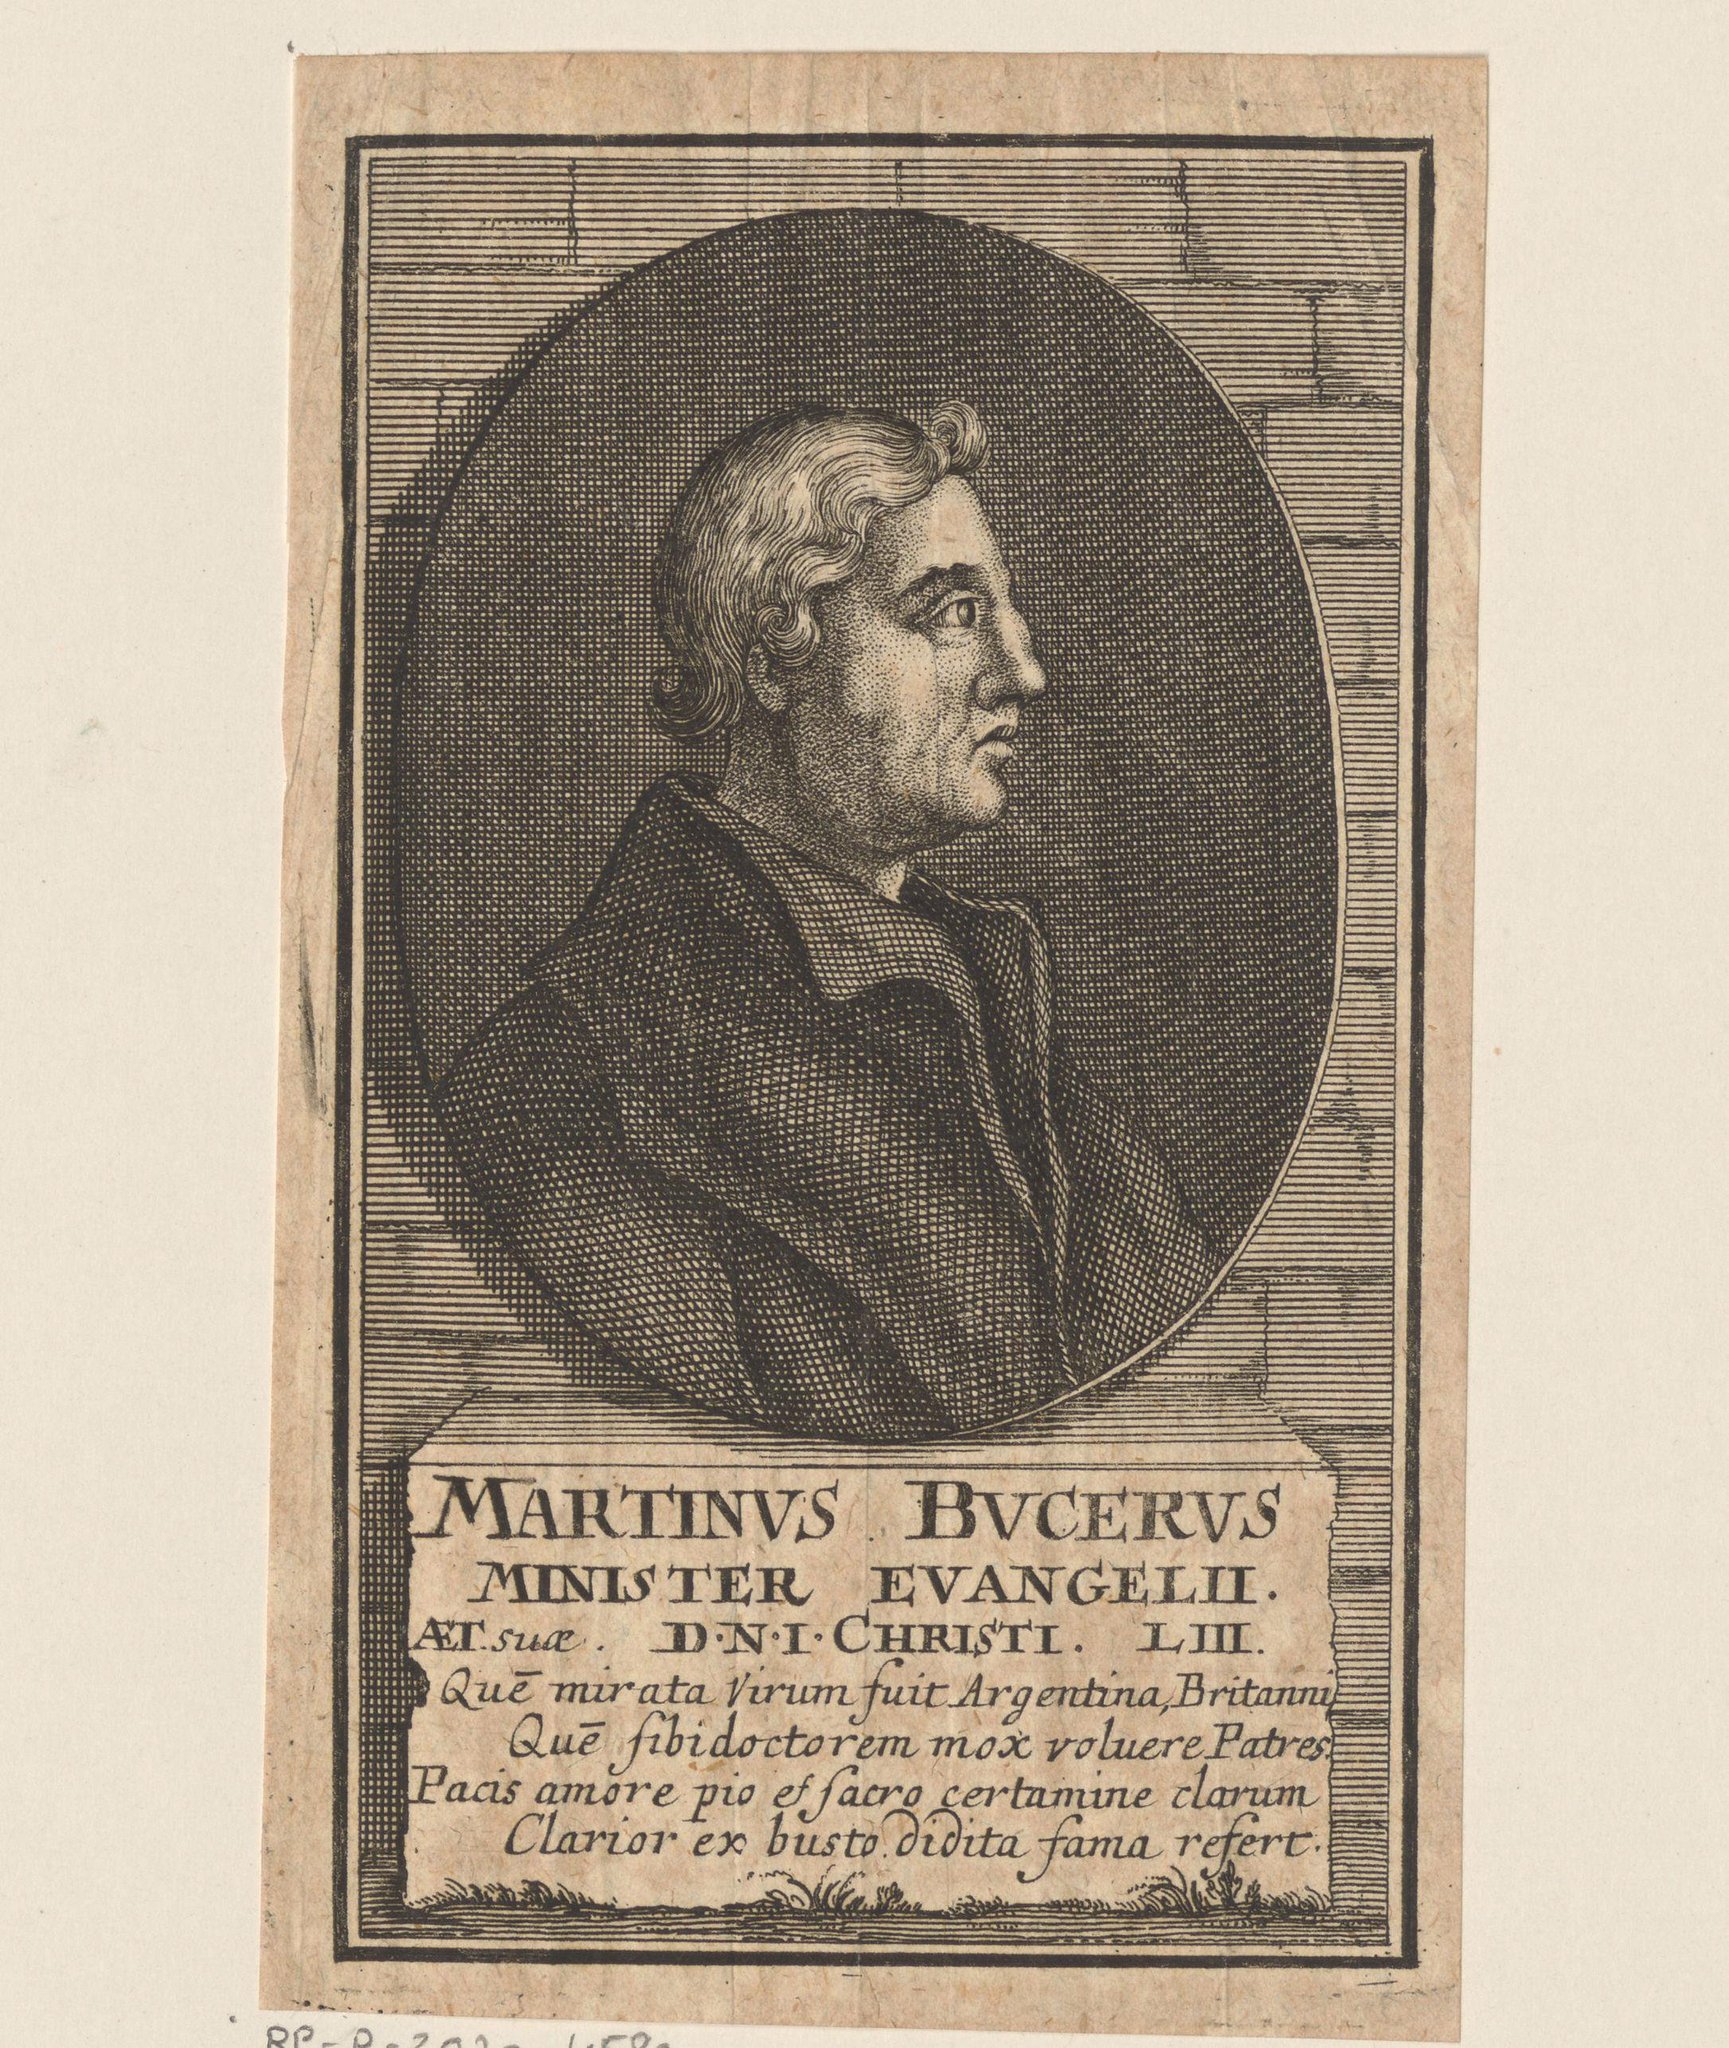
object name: print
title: Portret van Martin Bucer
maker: Anonymous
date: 1700-1749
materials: paper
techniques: engraving, etching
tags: theologian, historical persons